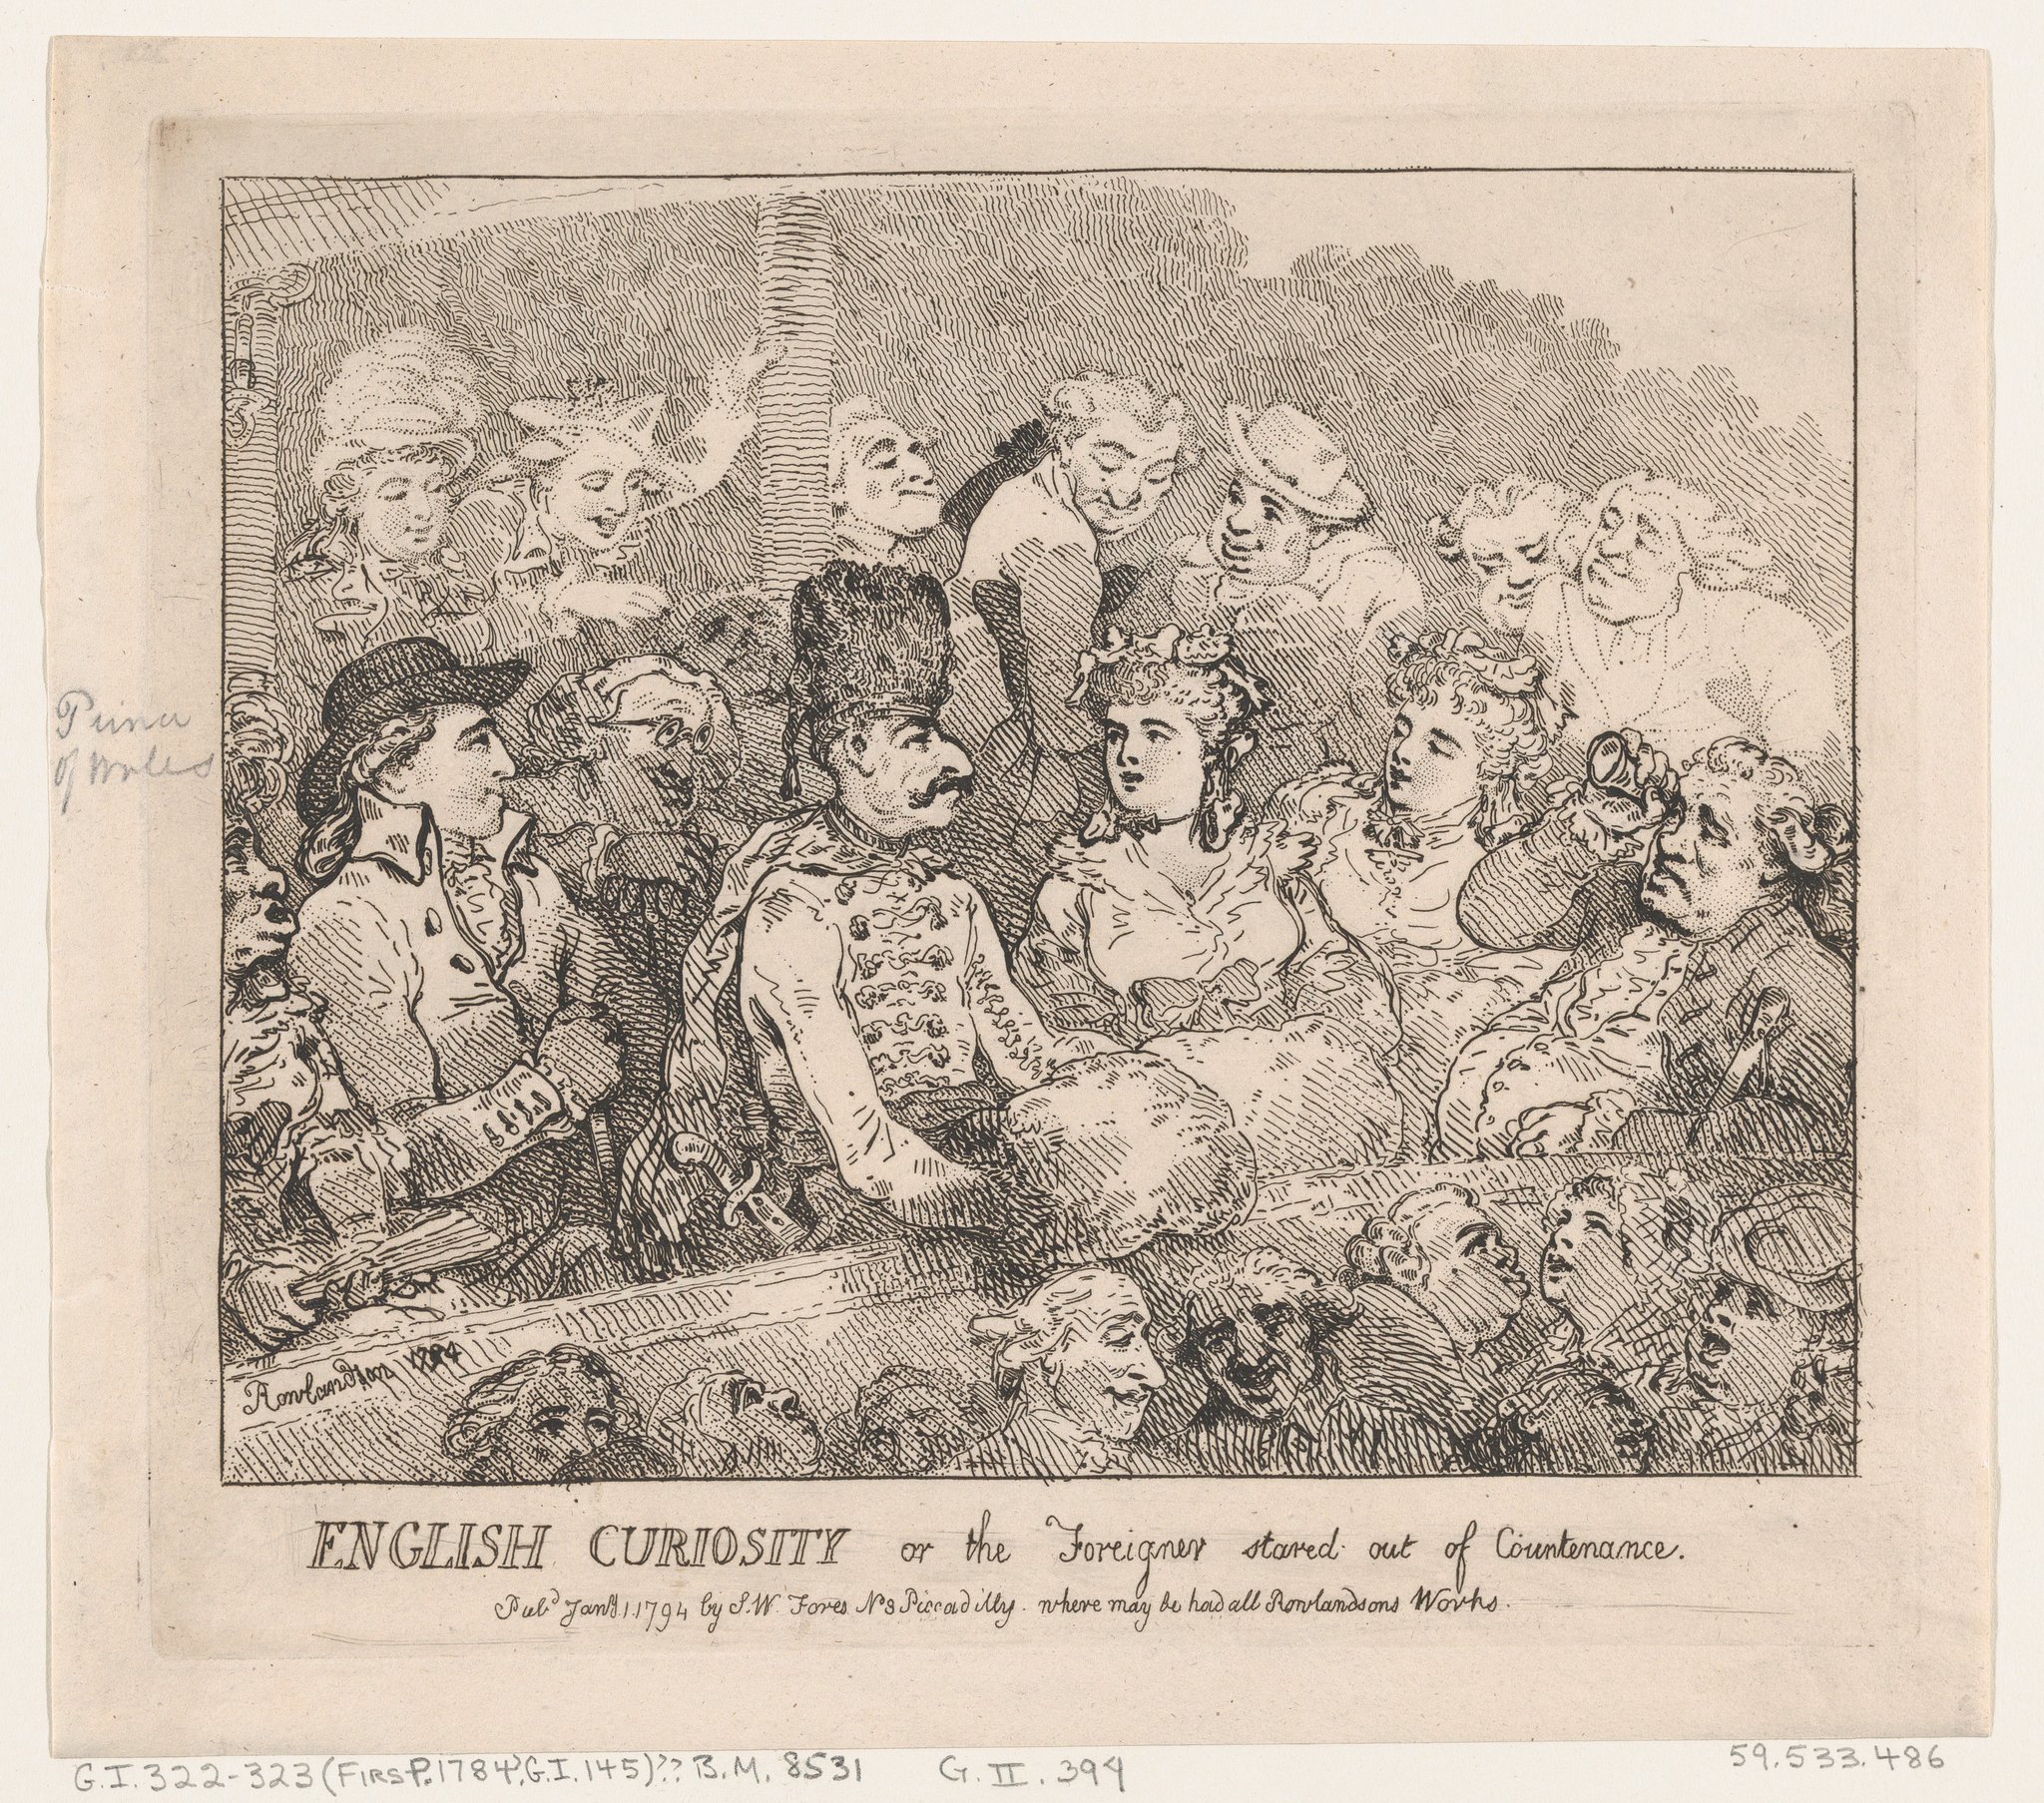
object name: print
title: English Curiosity or The Foreigner Stared Out of Countenance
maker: thomas rowlandson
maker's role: artist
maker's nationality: british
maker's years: 1757-1827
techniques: etching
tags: satire,men,women